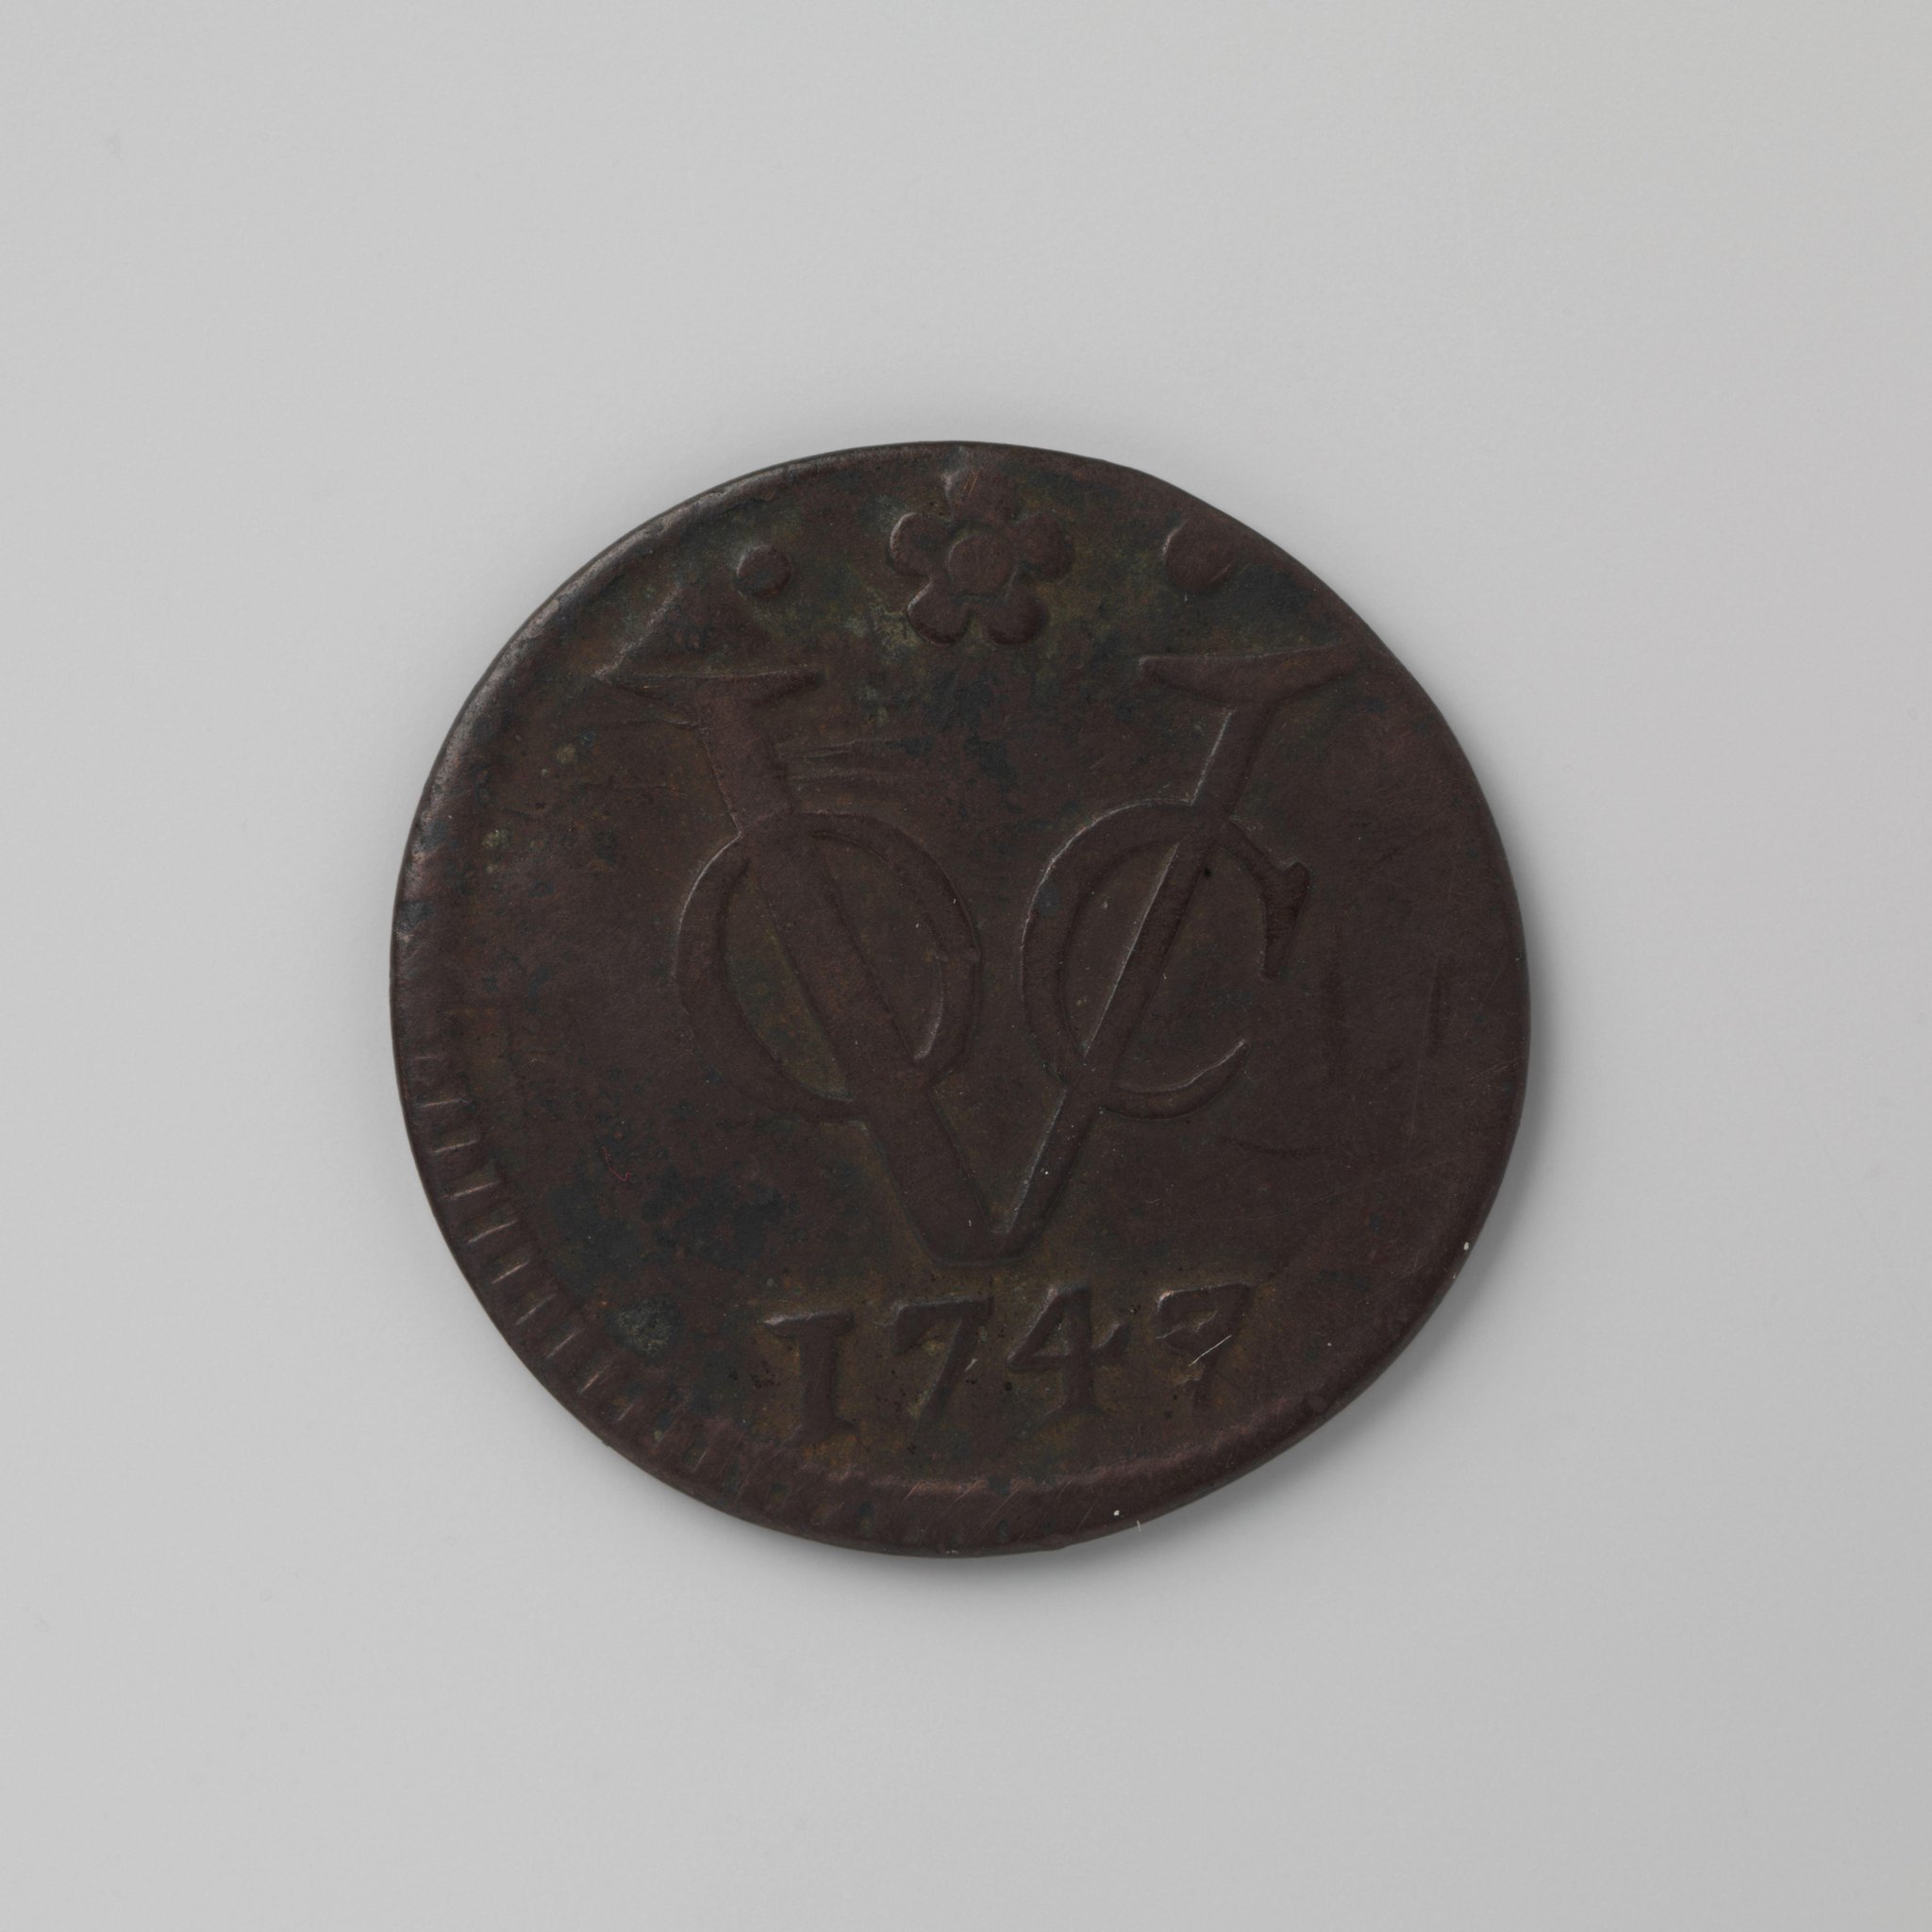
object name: coin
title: Duit van de VOC uit Holland, 1747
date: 1747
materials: copper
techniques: striking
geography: dordrecht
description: Koperen munt. Voorzijde: gekroond wapenschild van Holland. Keerzijde: monogram van de VOC, waarboven muntteken en waaronder jaartal. Gladde rand.